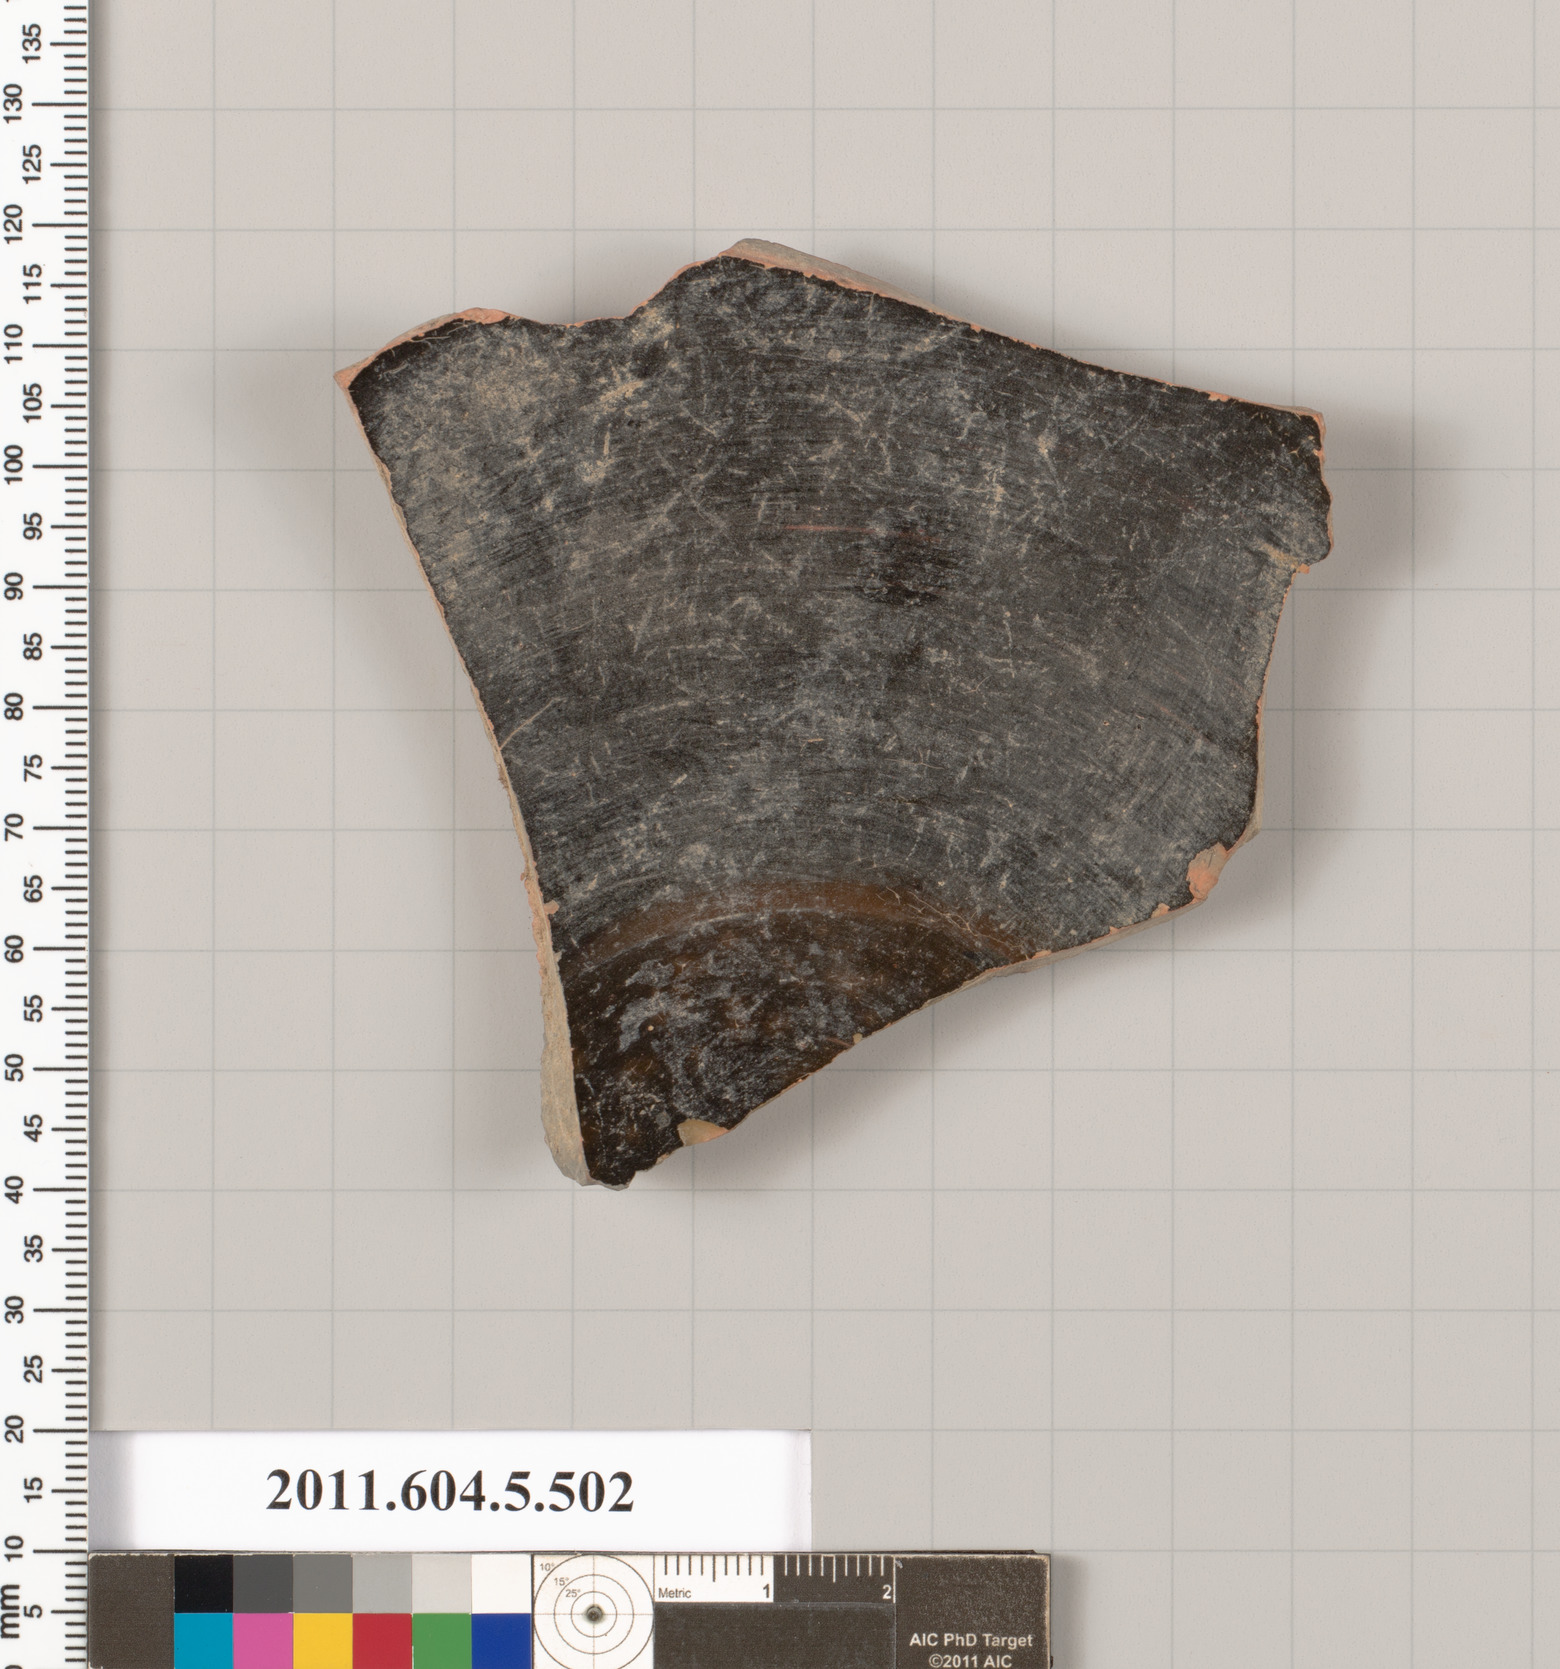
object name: kylix fragment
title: Terracotta fragment of a kylix (drinking cup)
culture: greek, attic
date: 600-401 BCE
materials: terracotta